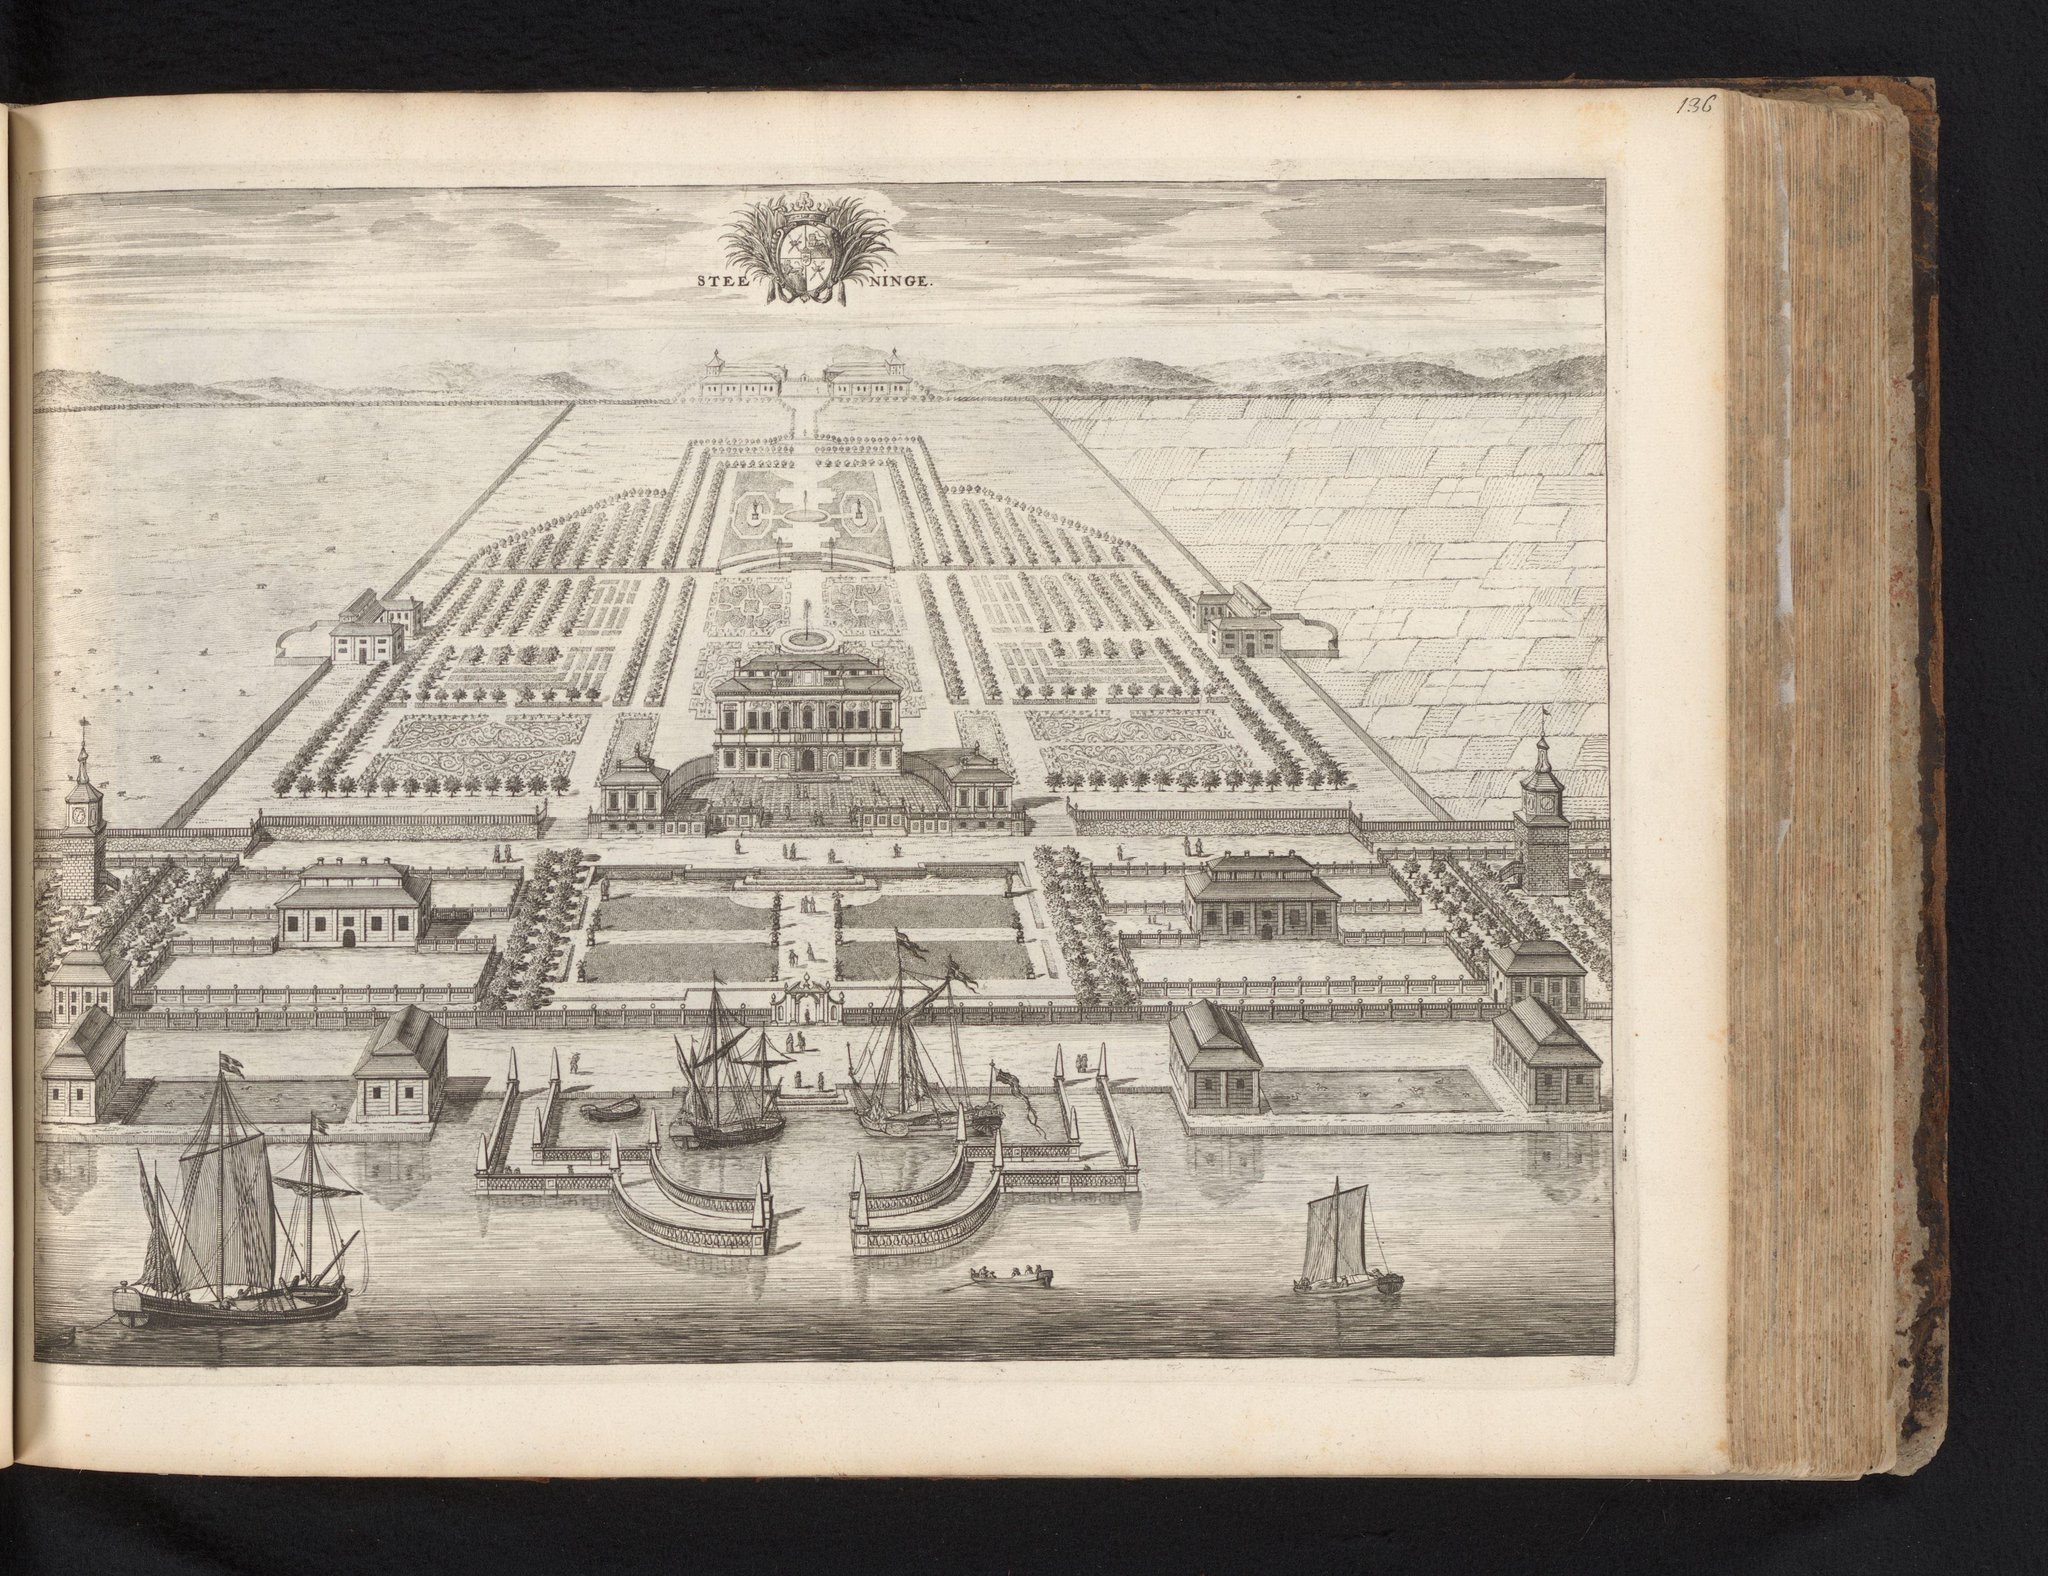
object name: album leaf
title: Suecia Antiqua et Hodierna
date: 1695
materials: paper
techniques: etching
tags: garden, housing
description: Kungliga Biblioteket, 'Suecia': http://www.kb.se/samlingarna/Kartor-bilder/Suecia-antiqua/ (geraadpleegd november 2016).